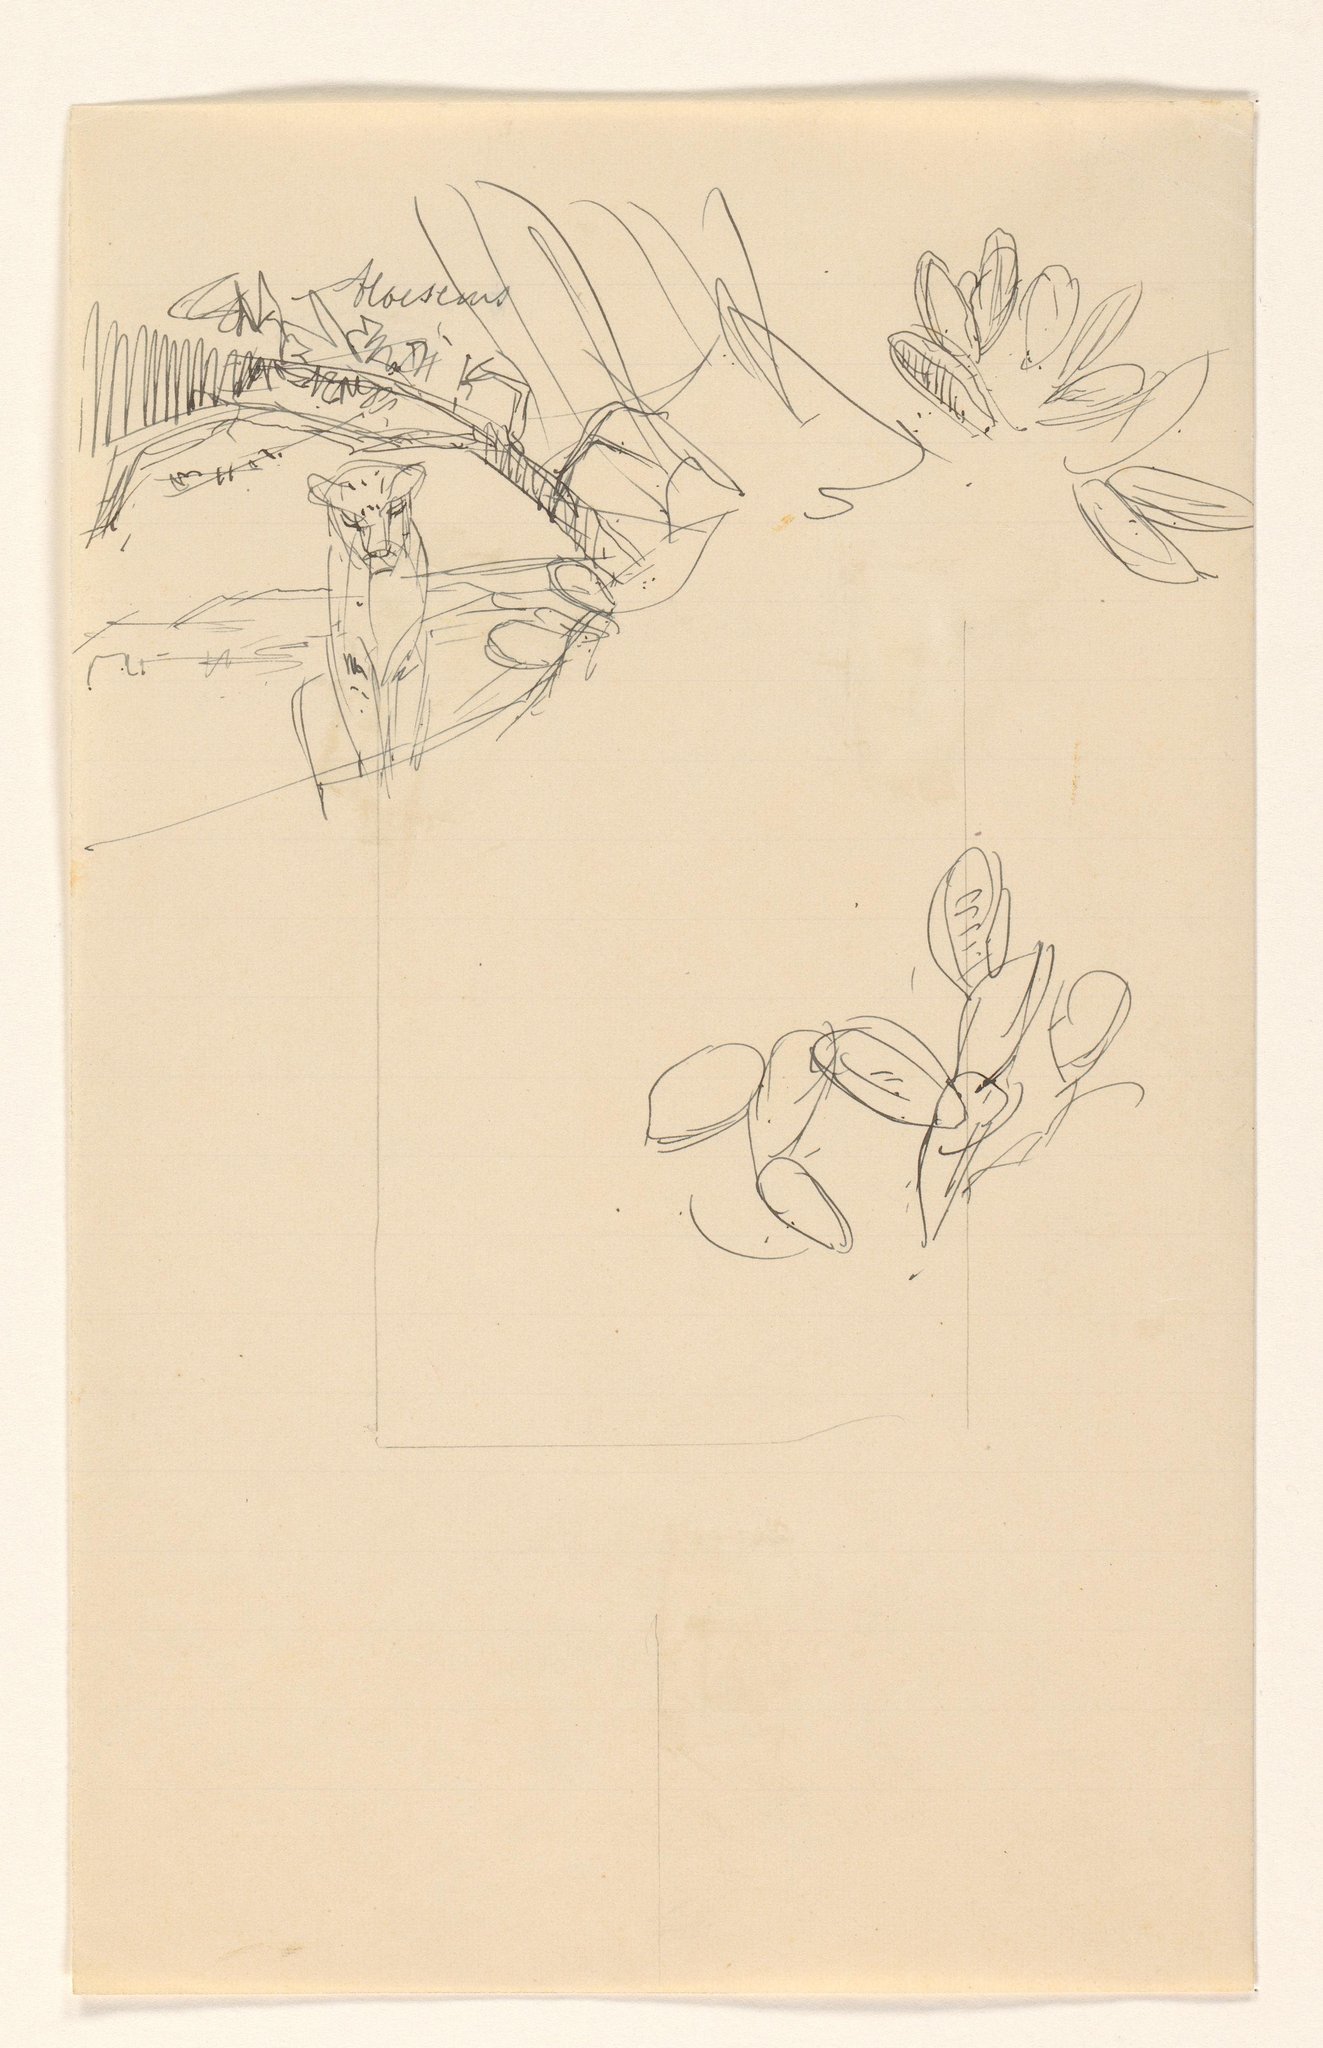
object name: drawing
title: Schetsblad met leeuwtje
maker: august allebé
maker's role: draughtsman, print maker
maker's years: 1838-1927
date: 1848-1927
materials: ink, paper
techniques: pen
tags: beasts of prey, predatory animals: lion